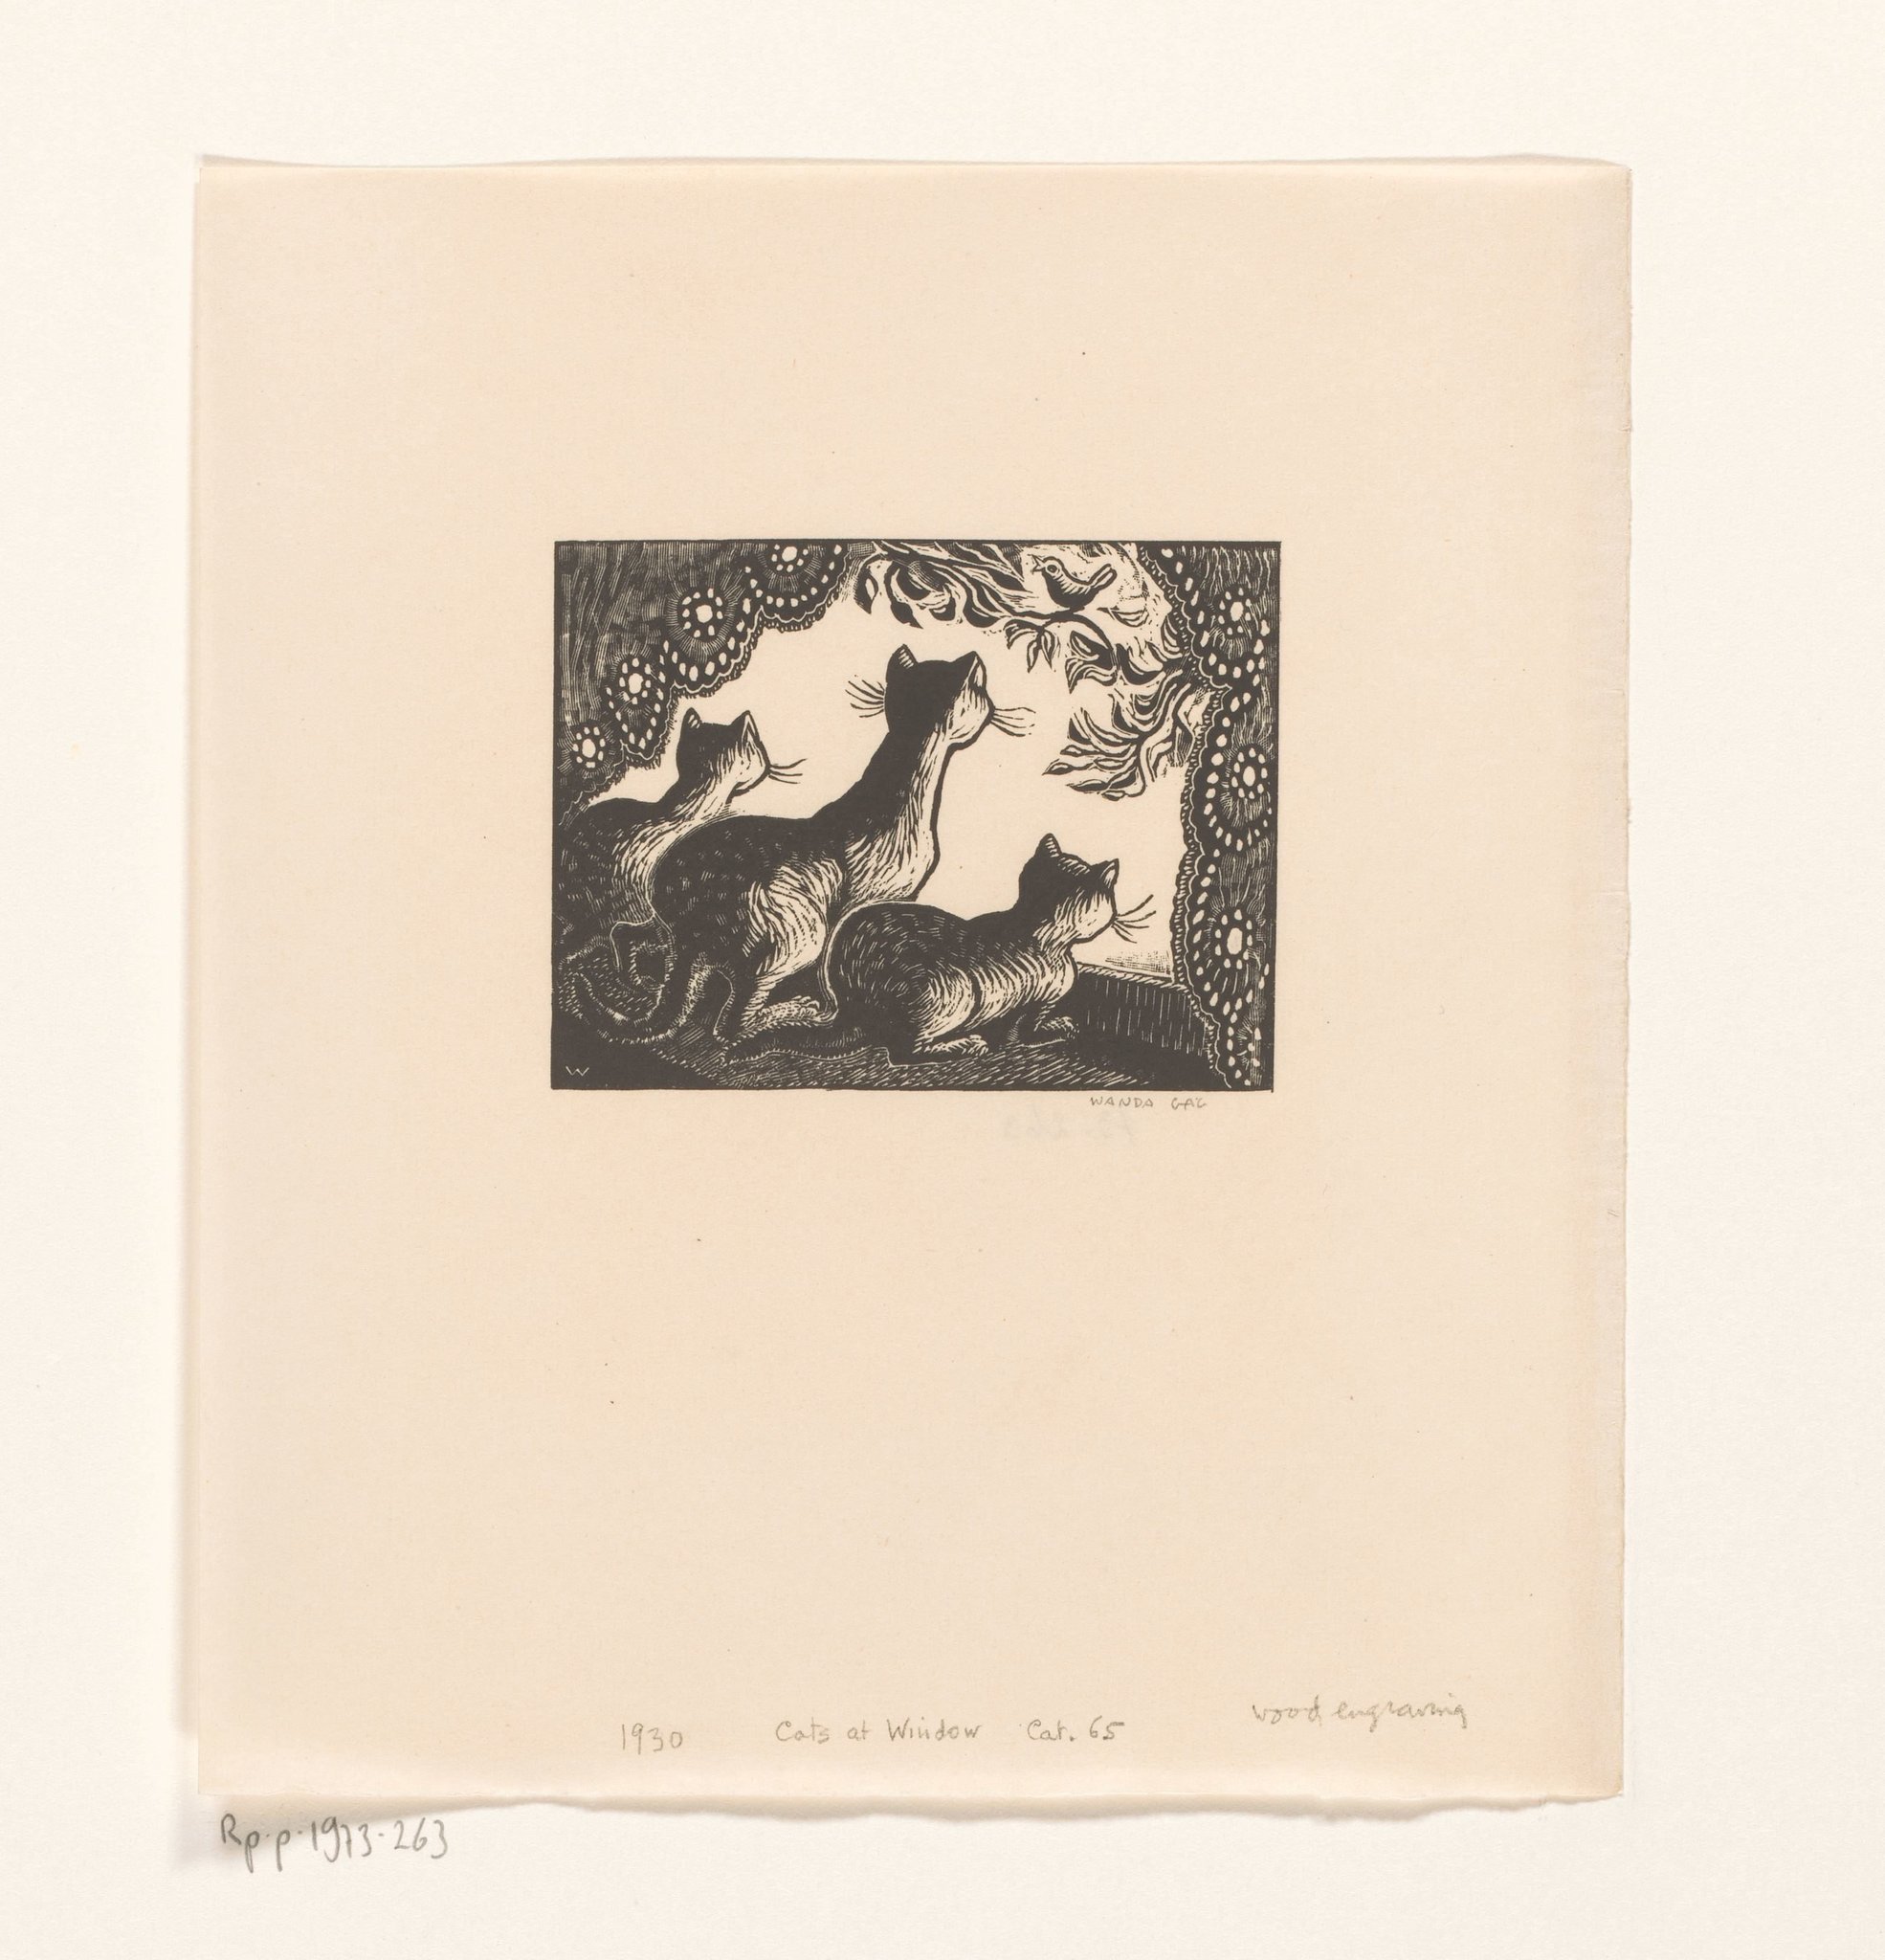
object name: print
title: Drie katten in een raamkozijn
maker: wanda gág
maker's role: print maker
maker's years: 1893-1946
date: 1903-1946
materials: paper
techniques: engraving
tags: cat, closed window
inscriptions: collector's mark: Lugt 2228